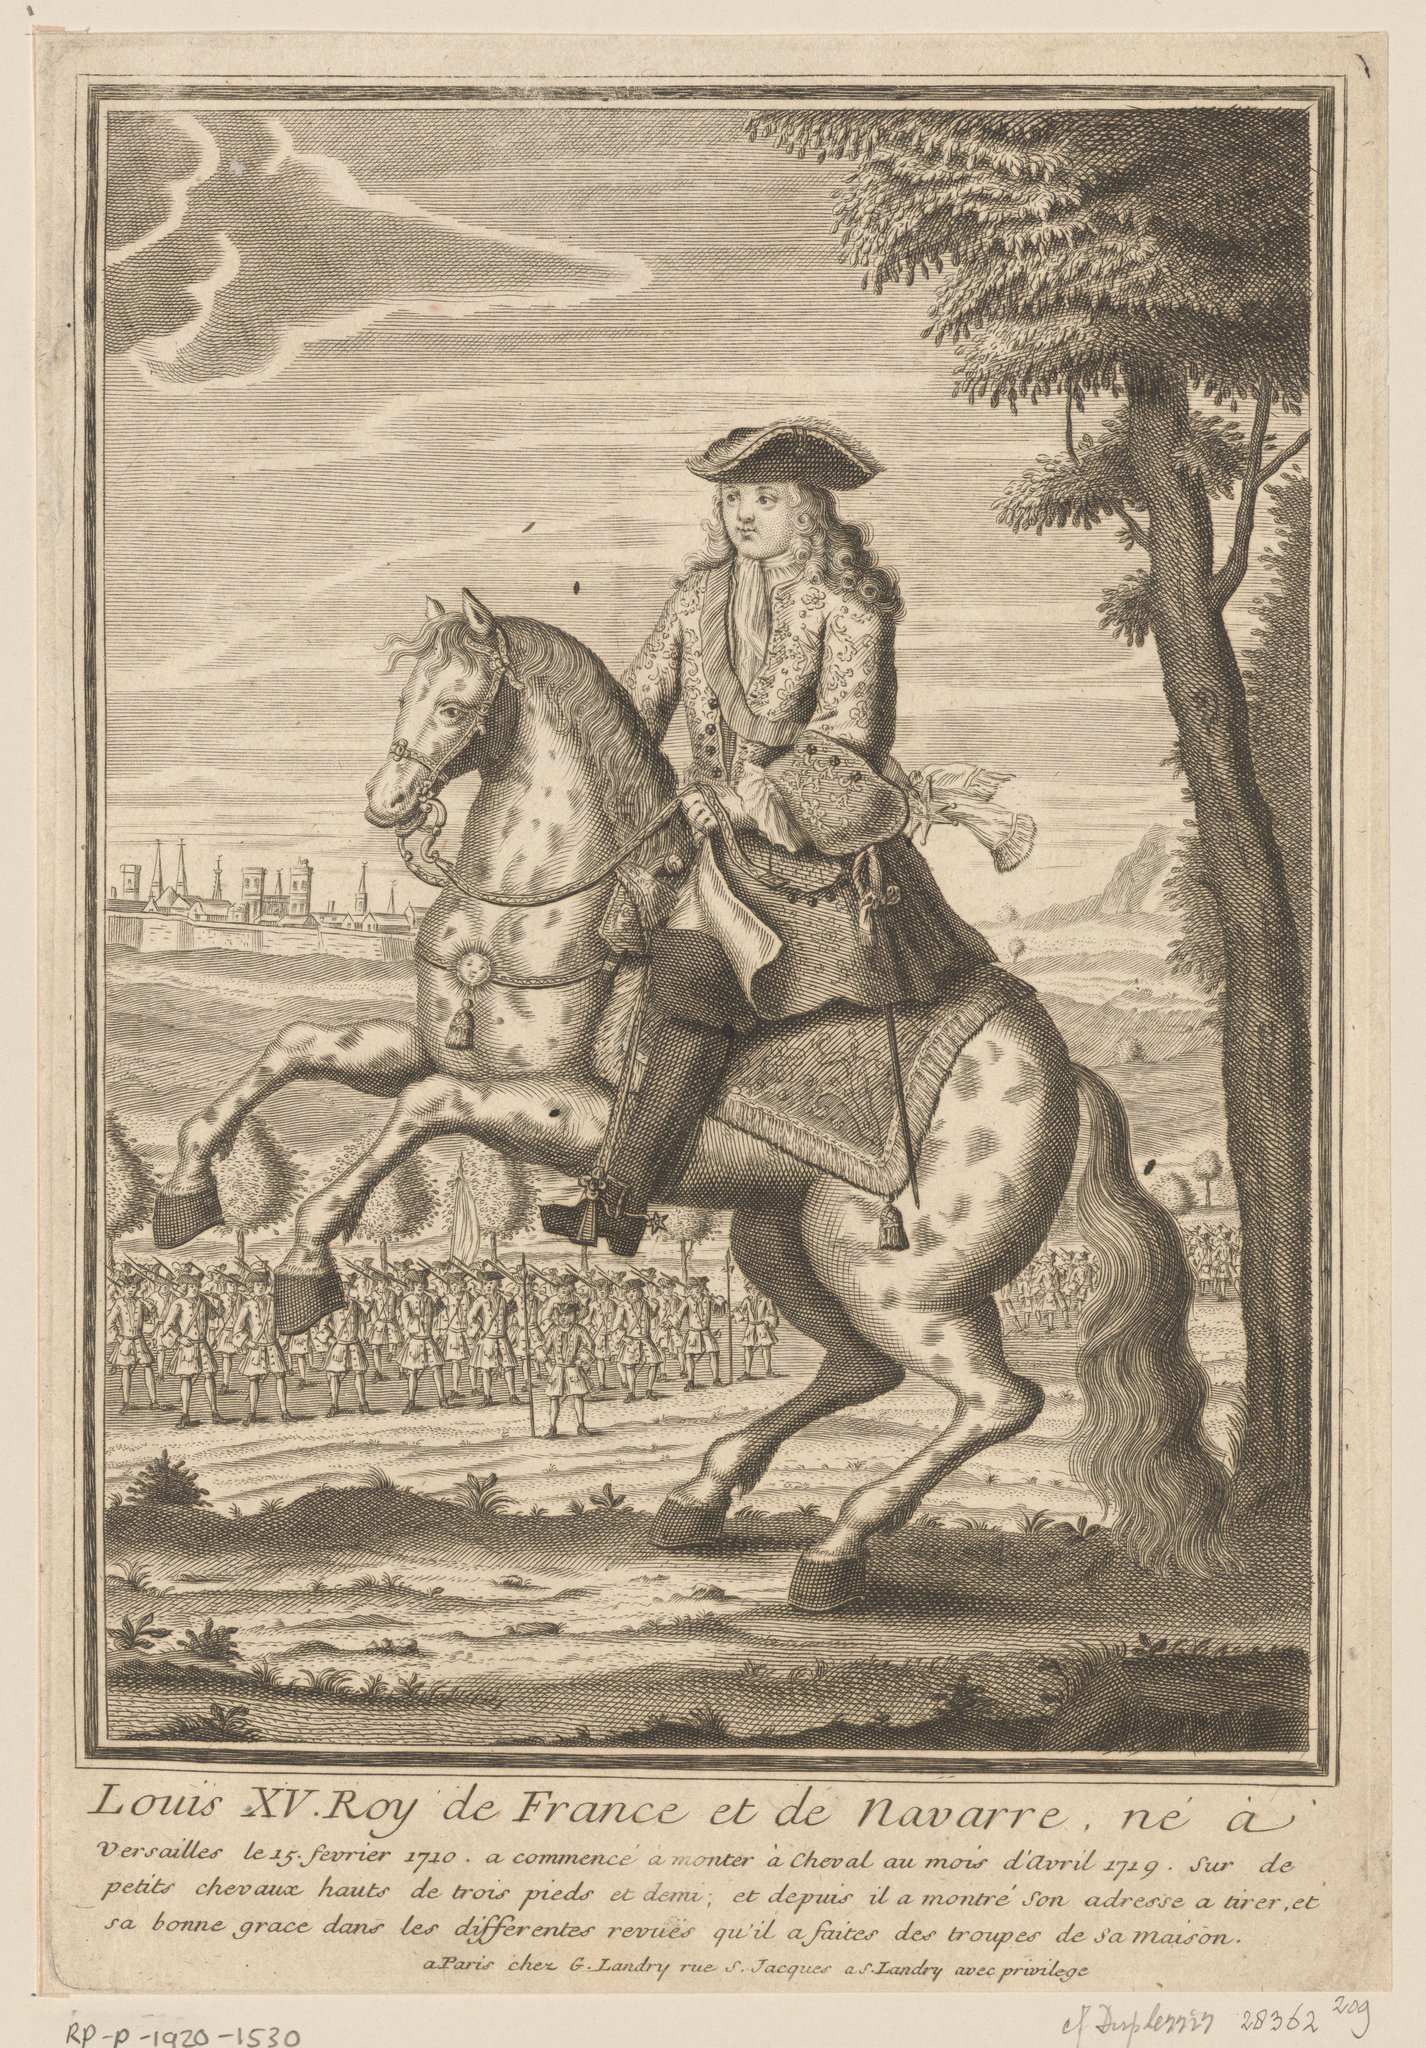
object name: print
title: Ruiterportret van Lodewijk XV van Frankrijk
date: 1719-1725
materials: paper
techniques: engraving, etching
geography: paris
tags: louis xv of france, equestrian state-portrait, historical persons, land forces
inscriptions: collector's mark: Lugt 2228